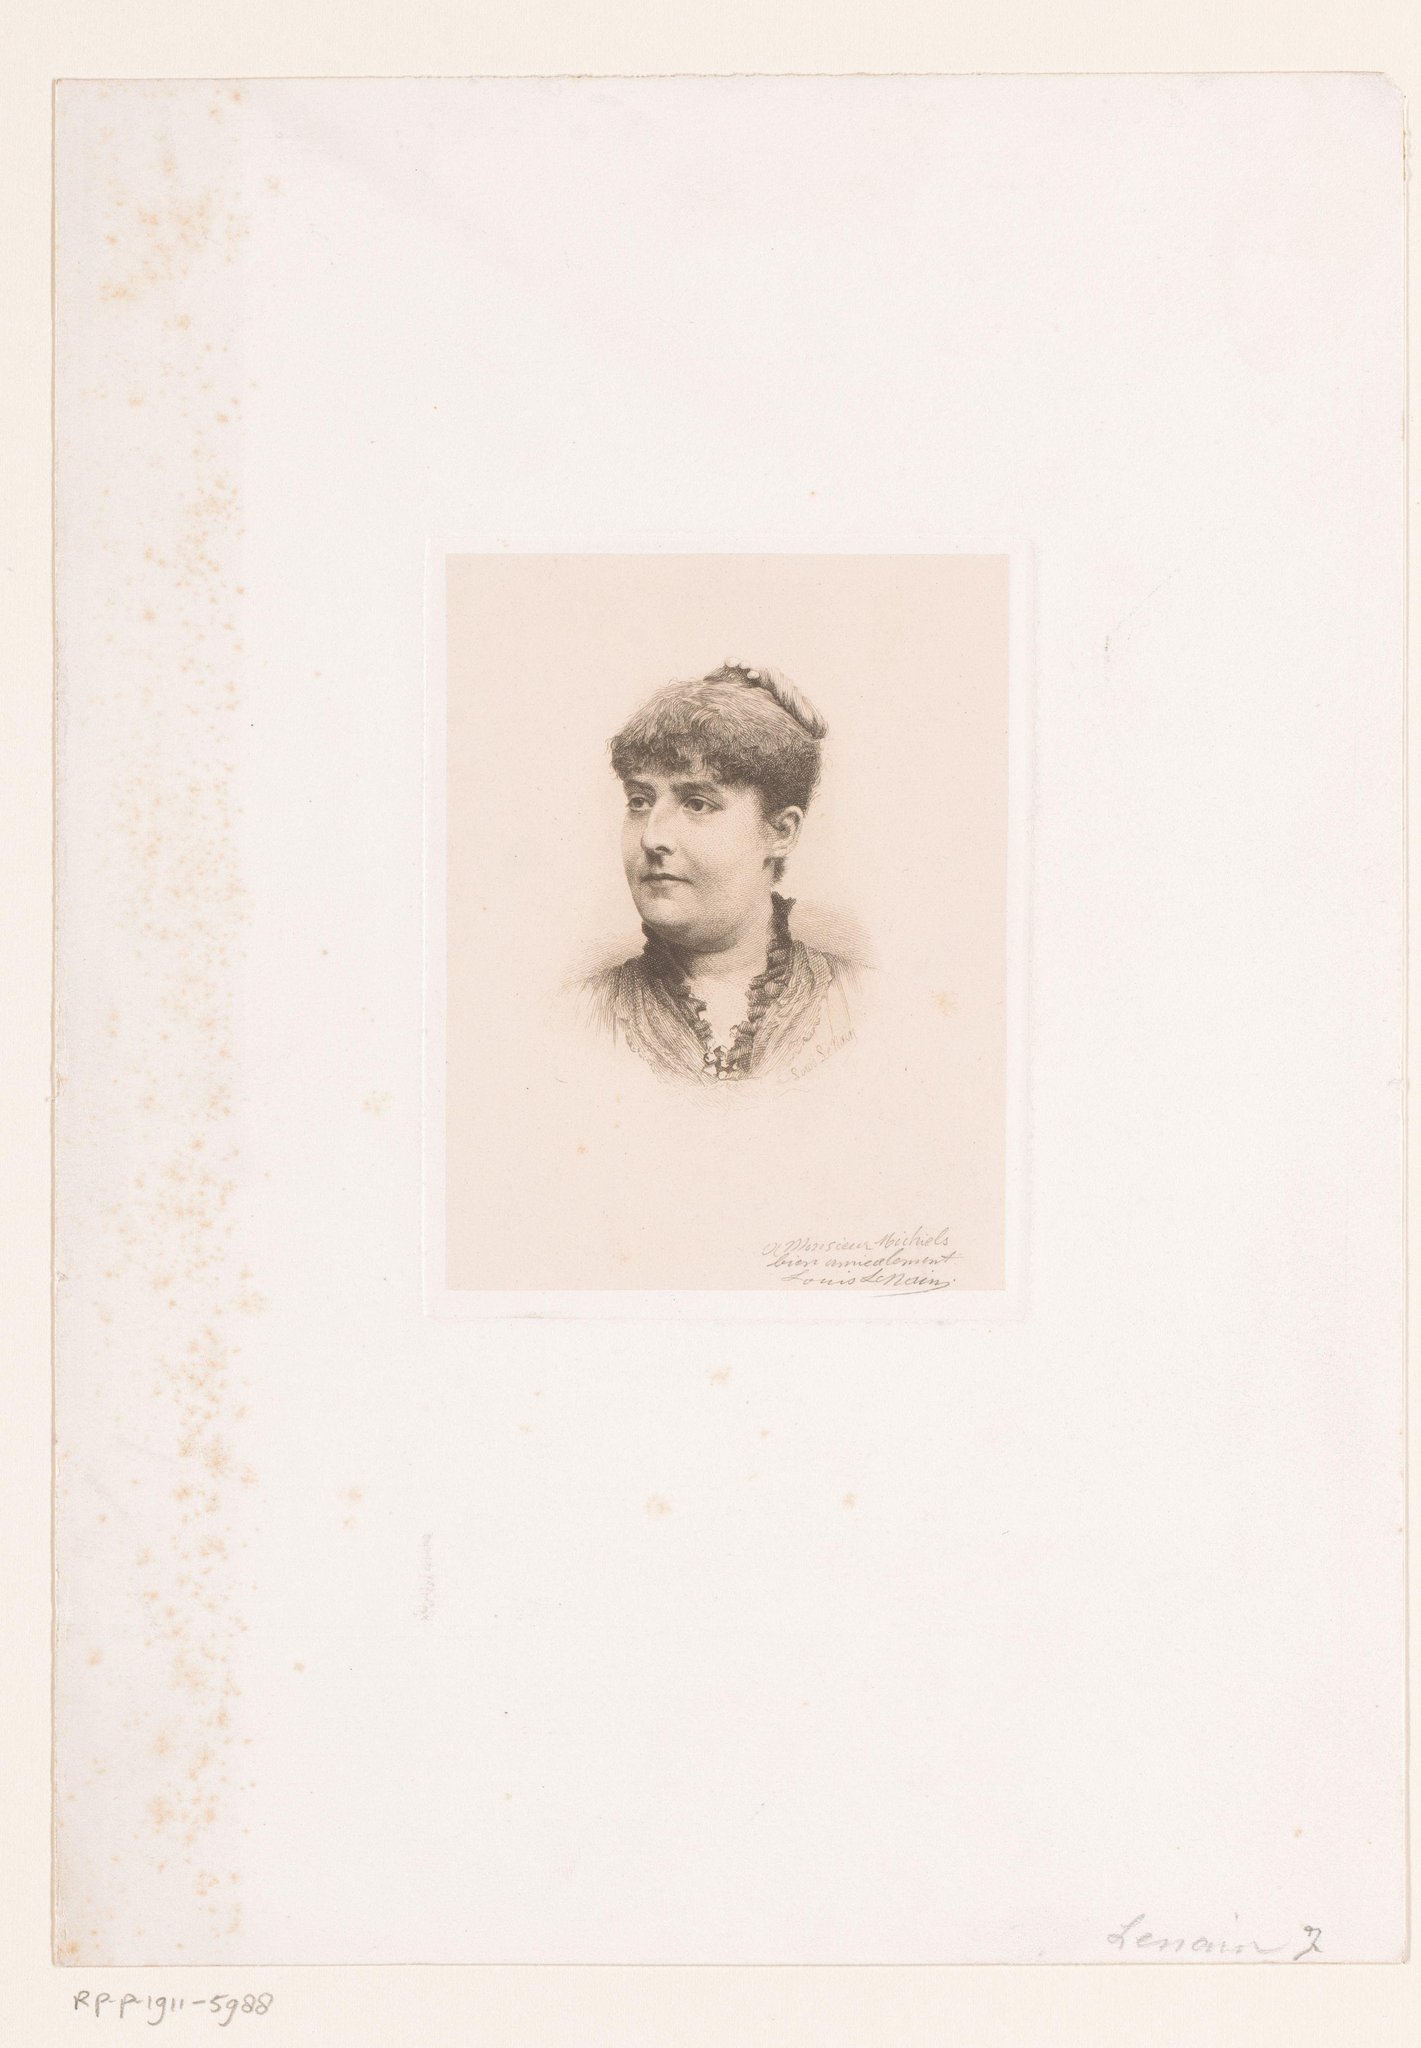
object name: print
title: Portret van een onbekende vrouw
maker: louis le nain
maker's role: print maker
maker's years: 1851-1939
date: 1861-1911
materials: paper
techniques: etching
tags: adult woman, historical persons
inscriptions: collector's mark: Lugt 2228, inscription: ‘A Monsieur Michiels bien amicalement, Louis le Nain’